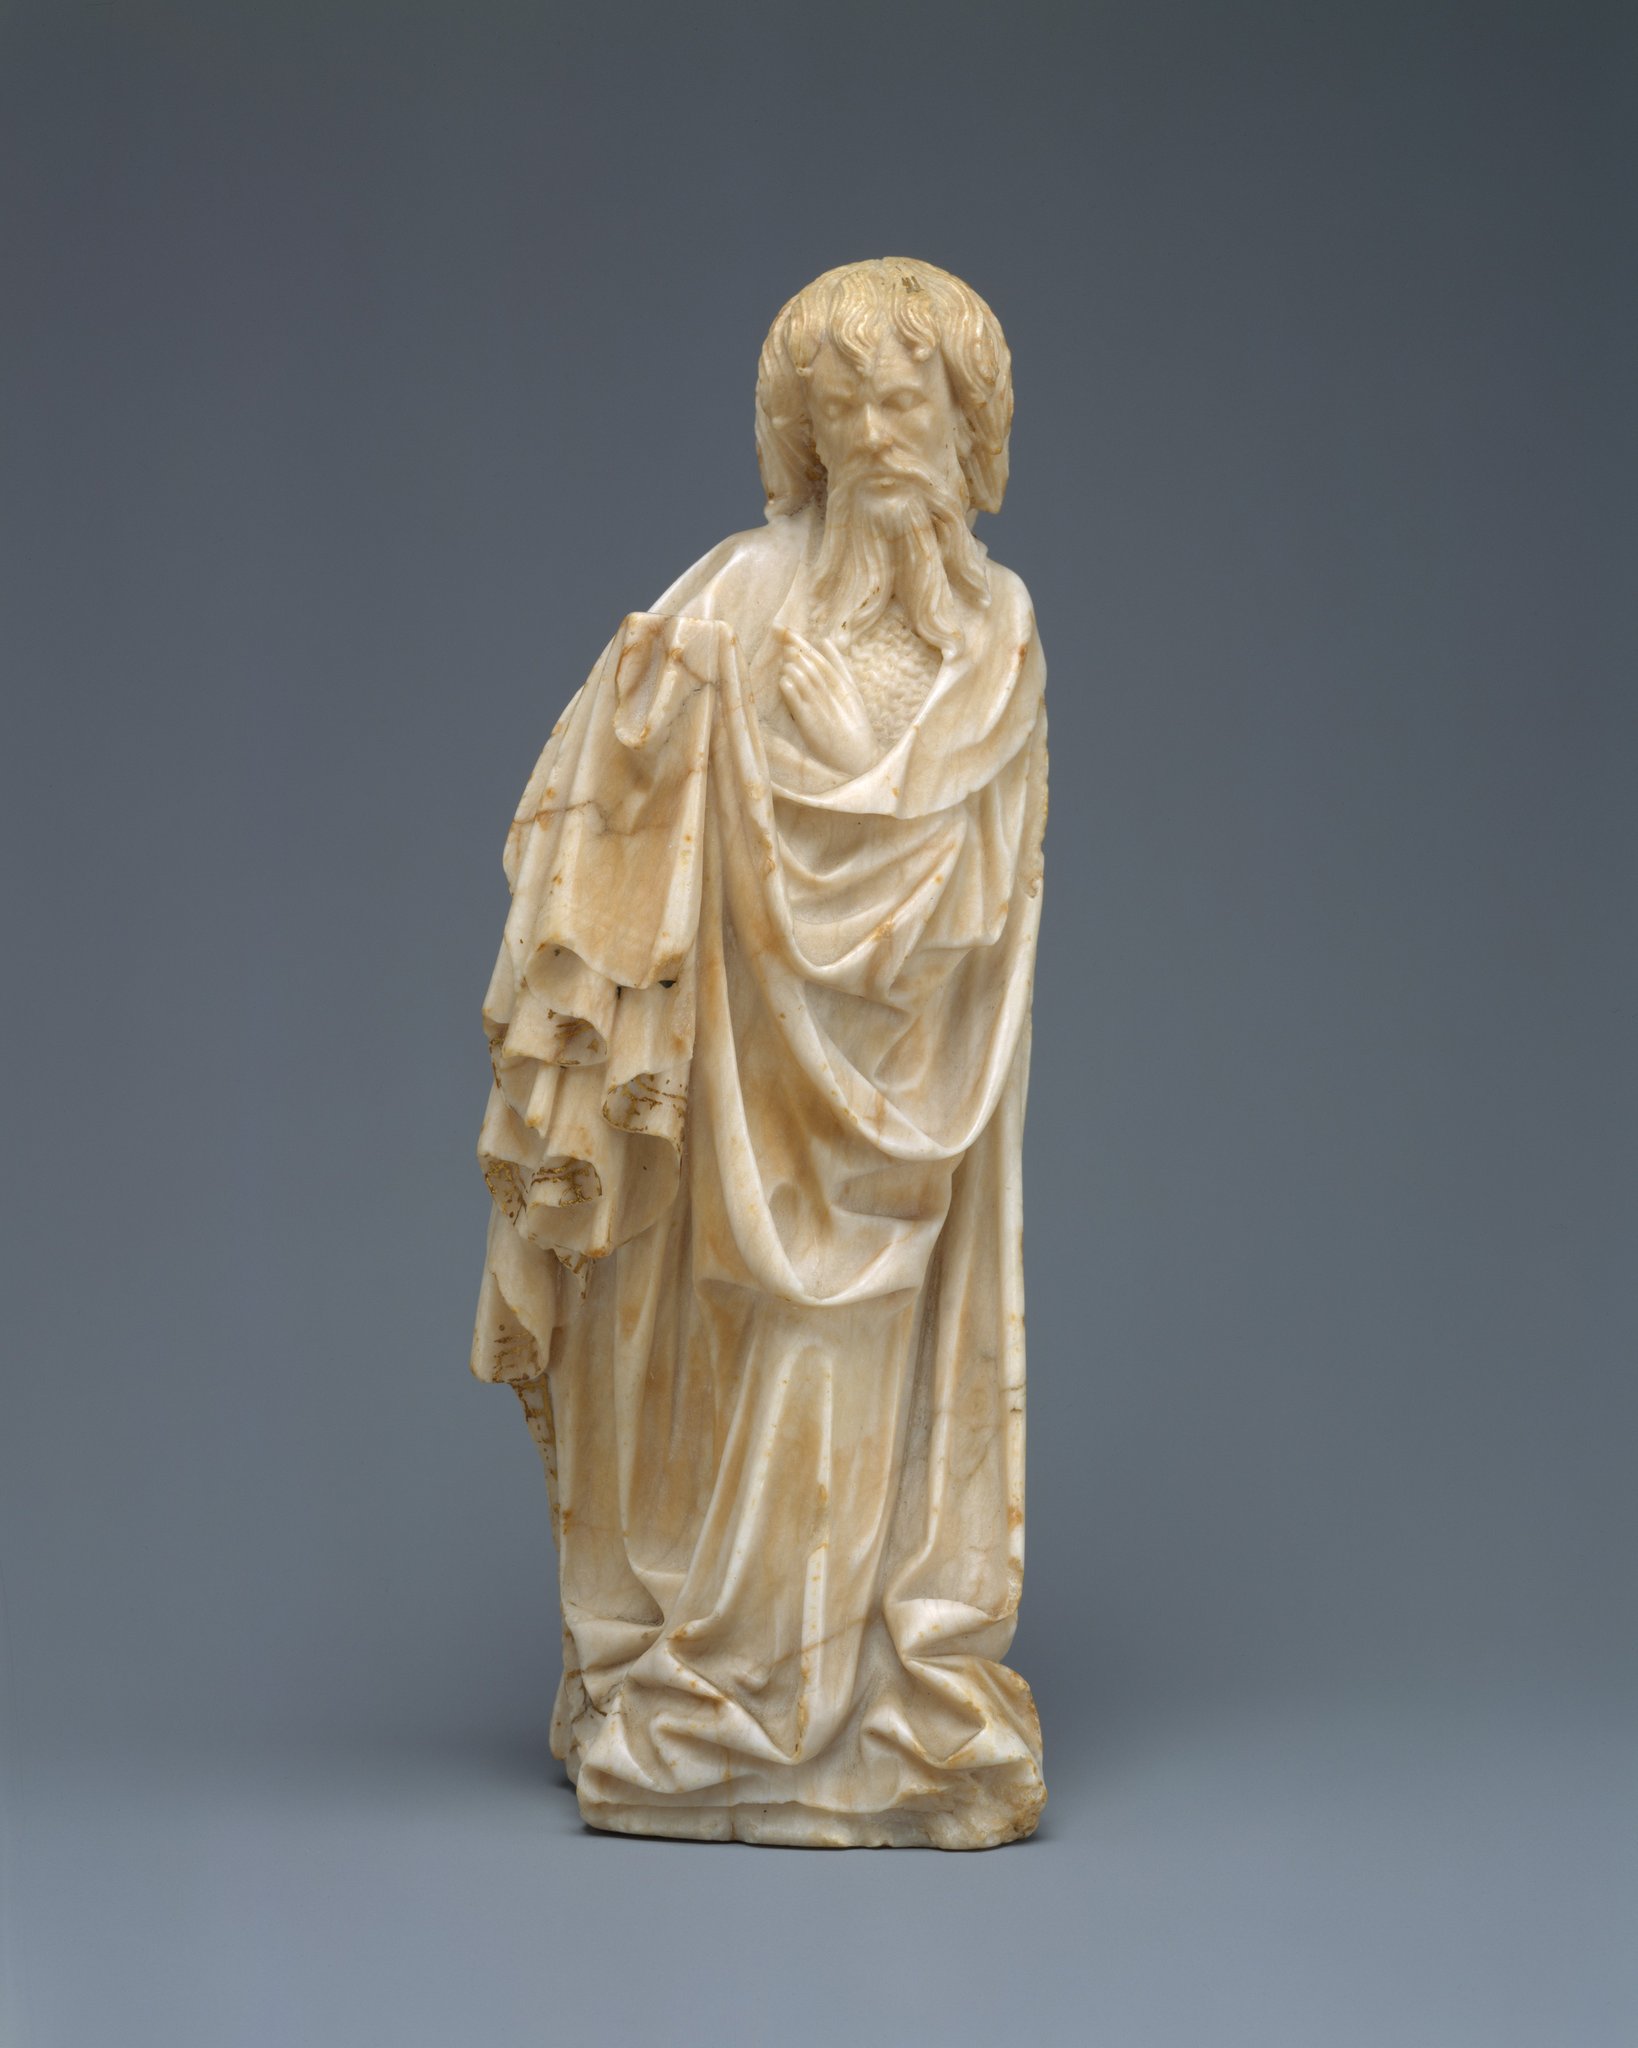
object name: statuette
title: Saint John the Baptist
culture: german or south netherlandish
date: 1420-1425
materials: alabaster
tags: men,saint john the baptist